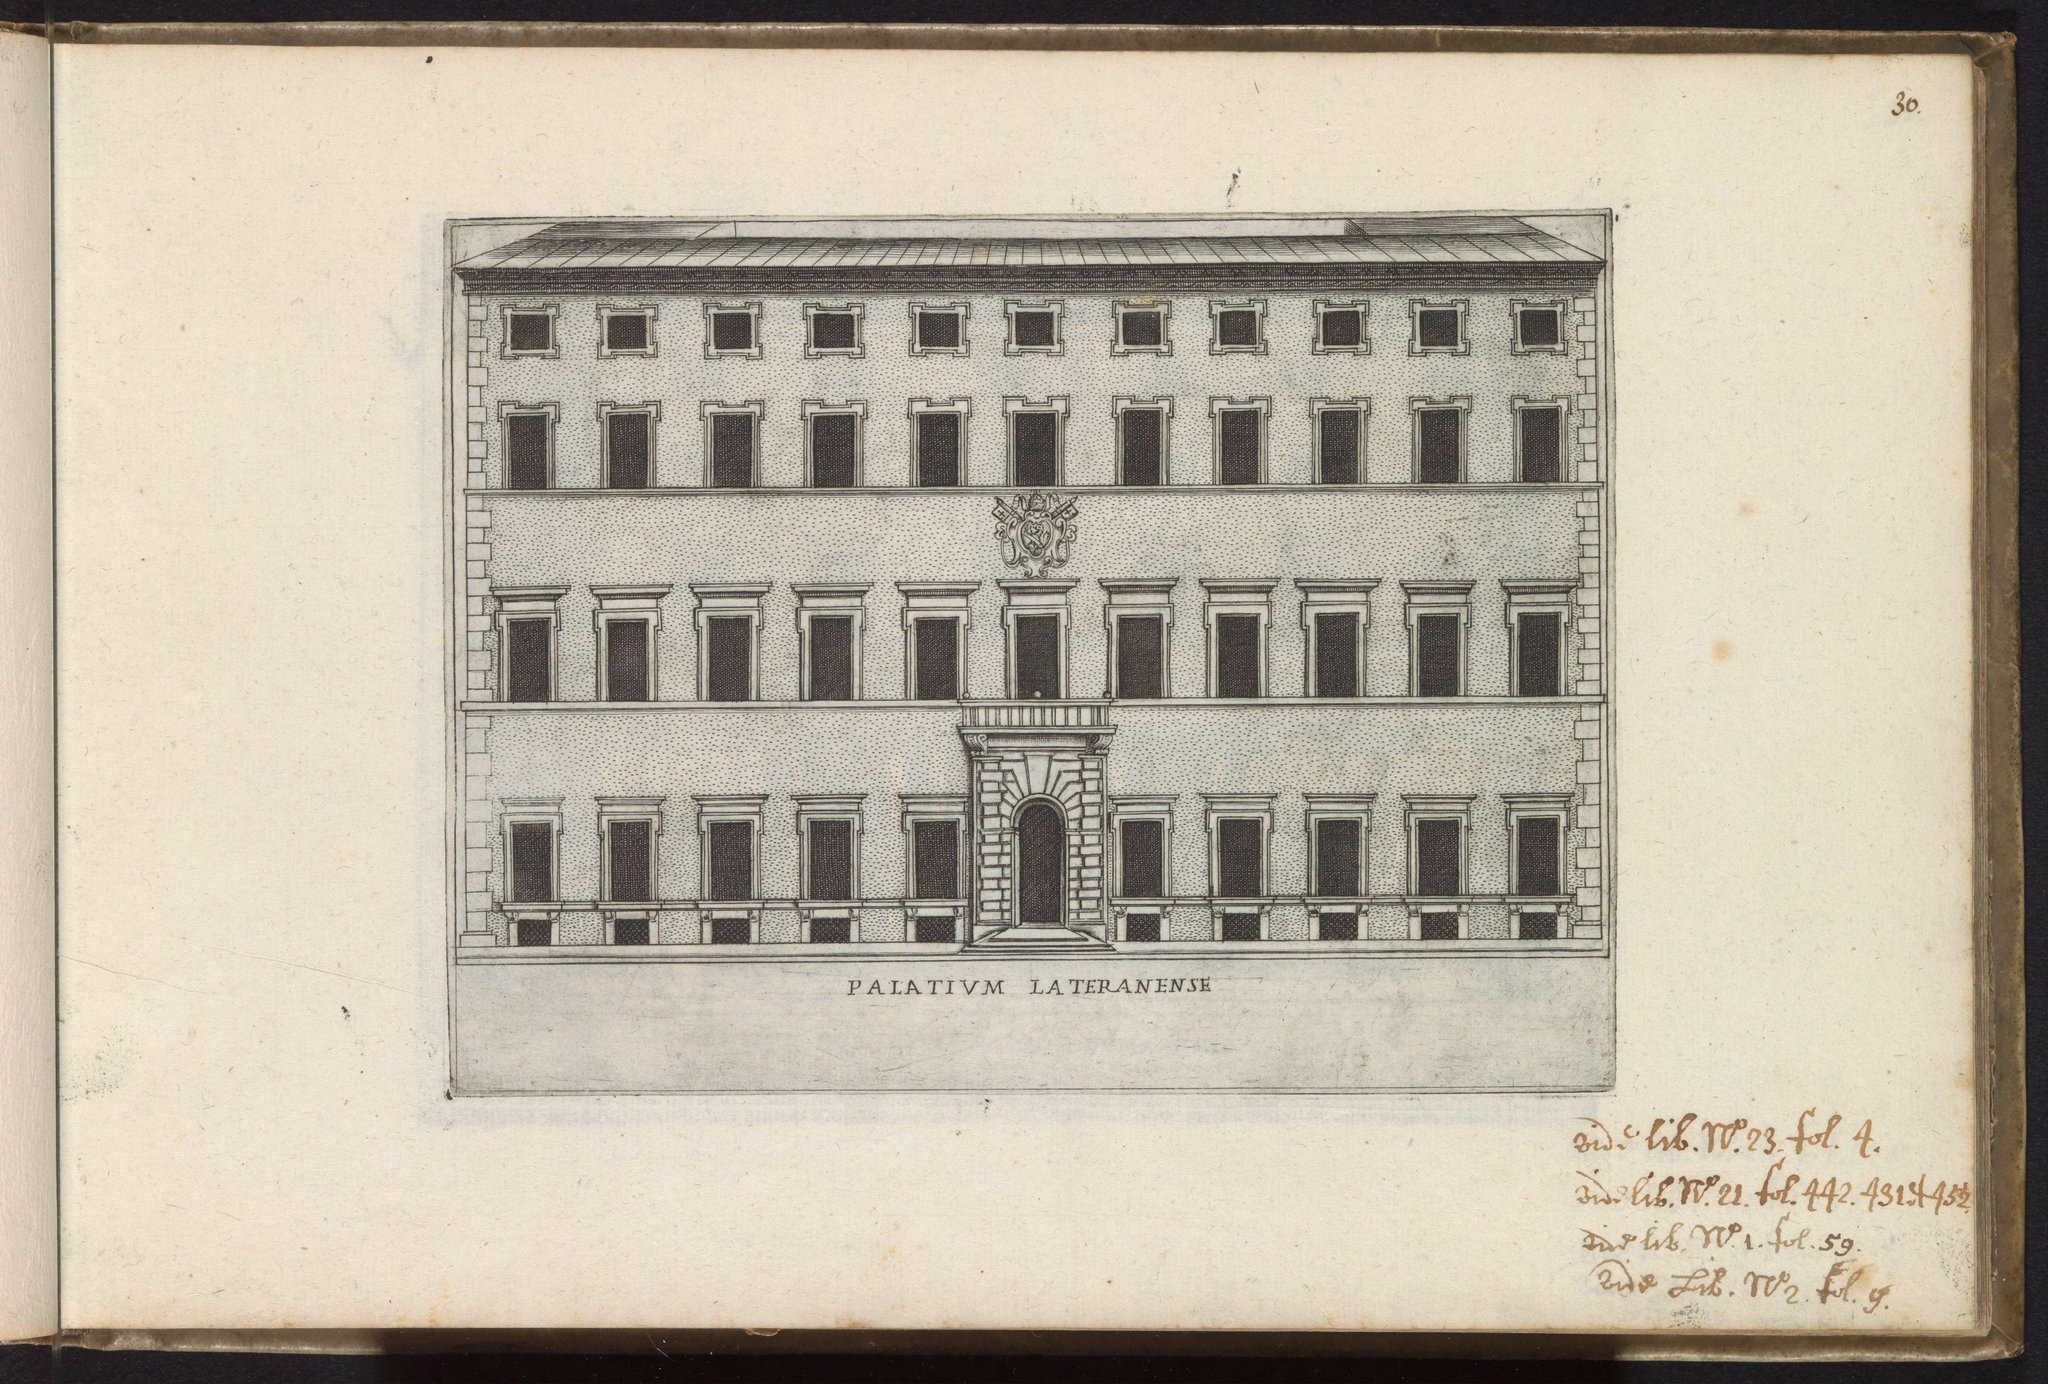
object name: print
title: Beroemde gebouwen in Rome en daarbuiten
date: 1638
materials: paper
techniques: etching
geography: rome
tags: hôtel, i.e. small palace in city, façade (of house or building)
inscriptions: number: ‘30’, inscription: ‘Ende lib. No. 23. fol. 4./ Ende lib. No. 21. fol. 442. 431 et 452...’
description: Prent maakt deel uit van een reeks prenten (+ titelprent) van beroemde gebouwen in Rome en elders.